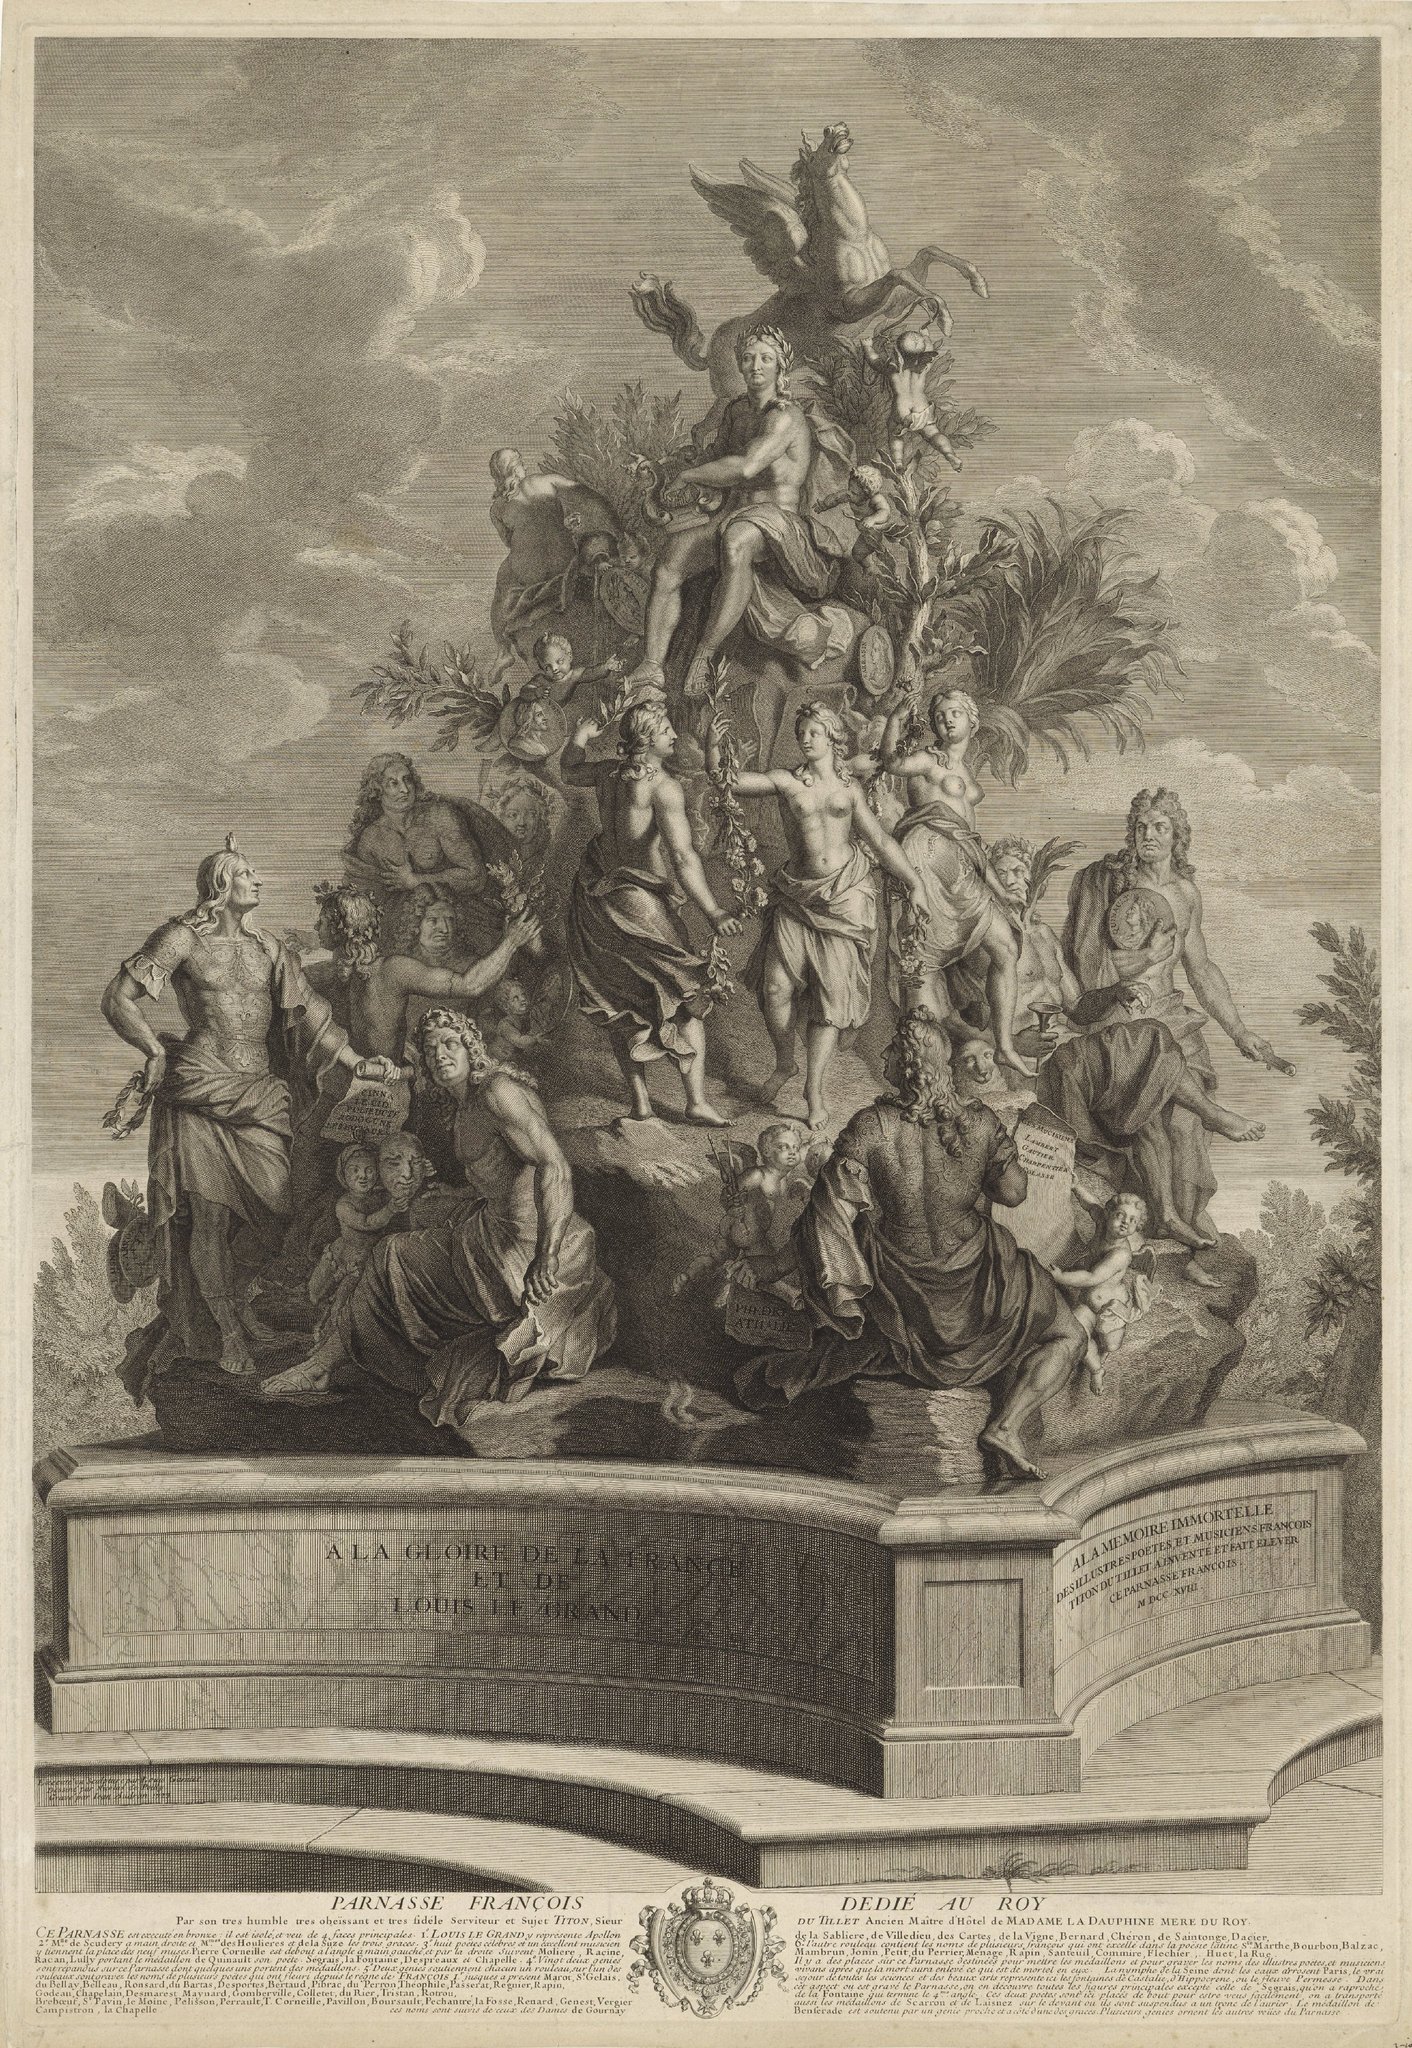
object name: print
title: Parnasse François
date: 1723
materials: paper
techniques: engraving, etching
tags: lodewijk xiv (koning van frankrijk), (story of the) muses; 'muse' (ripa), piece of sculpture, reproduction of a piece of sculpture, king, armorial bearing, heraldry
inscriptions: collector's mark: Lugt 2165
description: Met bovenaan Lodewijk XIV, koning van Frankrijk, afgebeeld als Apollo, omringd door Franse dichters en muzikanten en muzen.